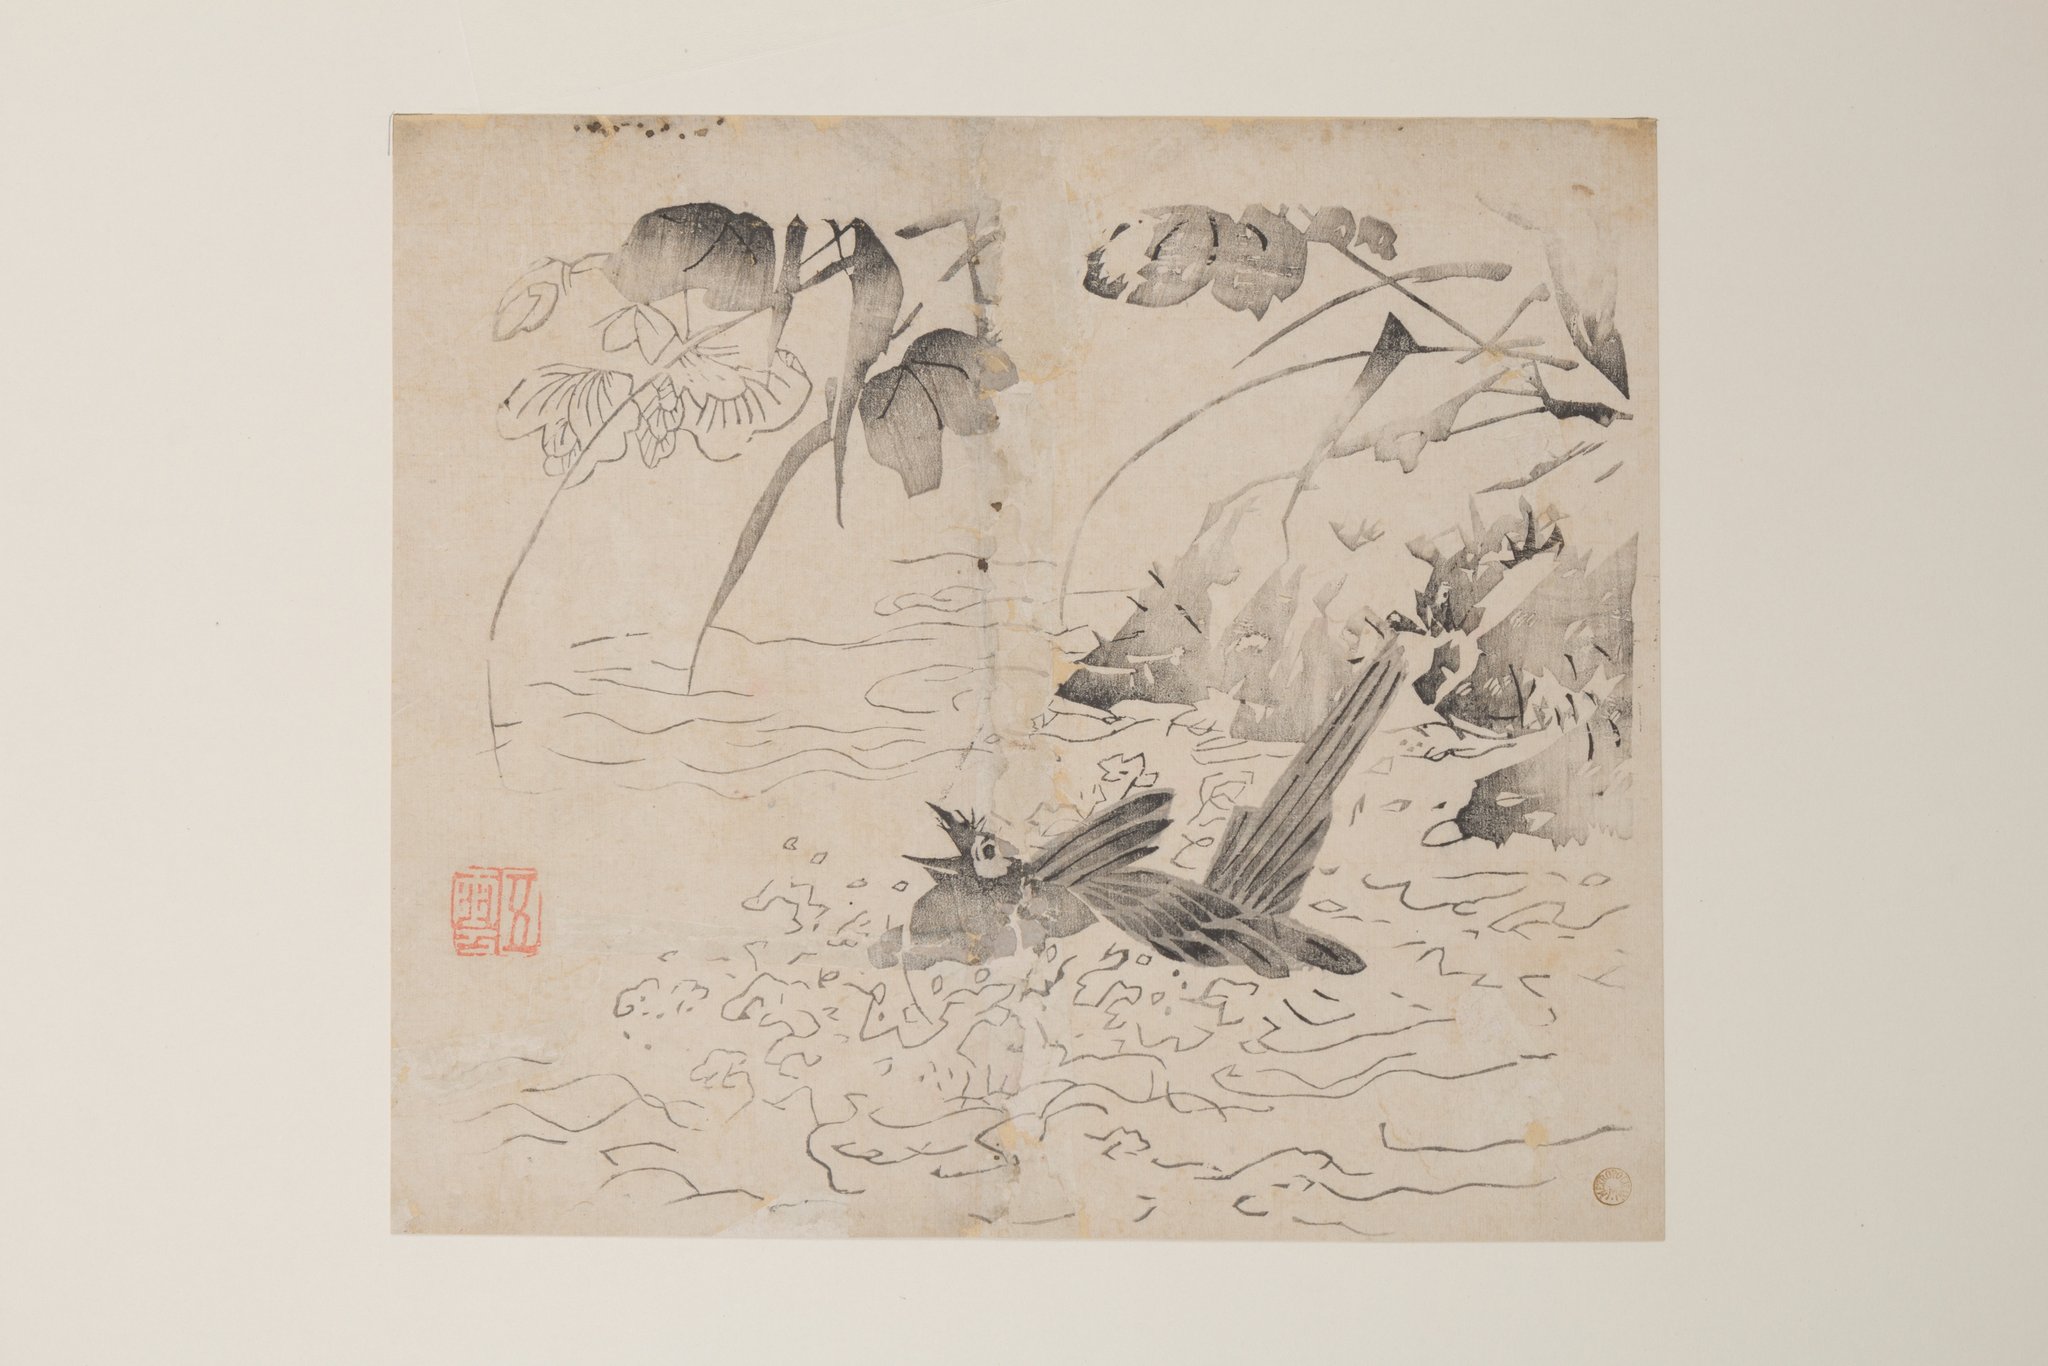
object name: print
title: Leaf from the Ten Bamboo Studio Manual of Painting and Calligraphy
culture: chinese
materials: ink, paper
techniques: printing